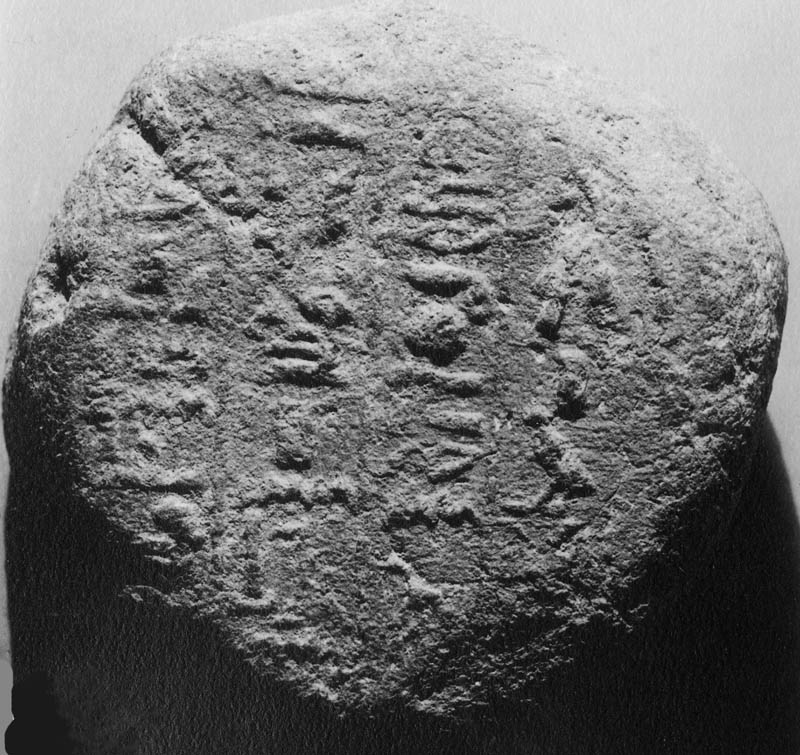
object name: cone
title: Funerary Cone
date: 1550-1295 BCE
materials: pottery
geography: egypt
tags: hieroglyphs